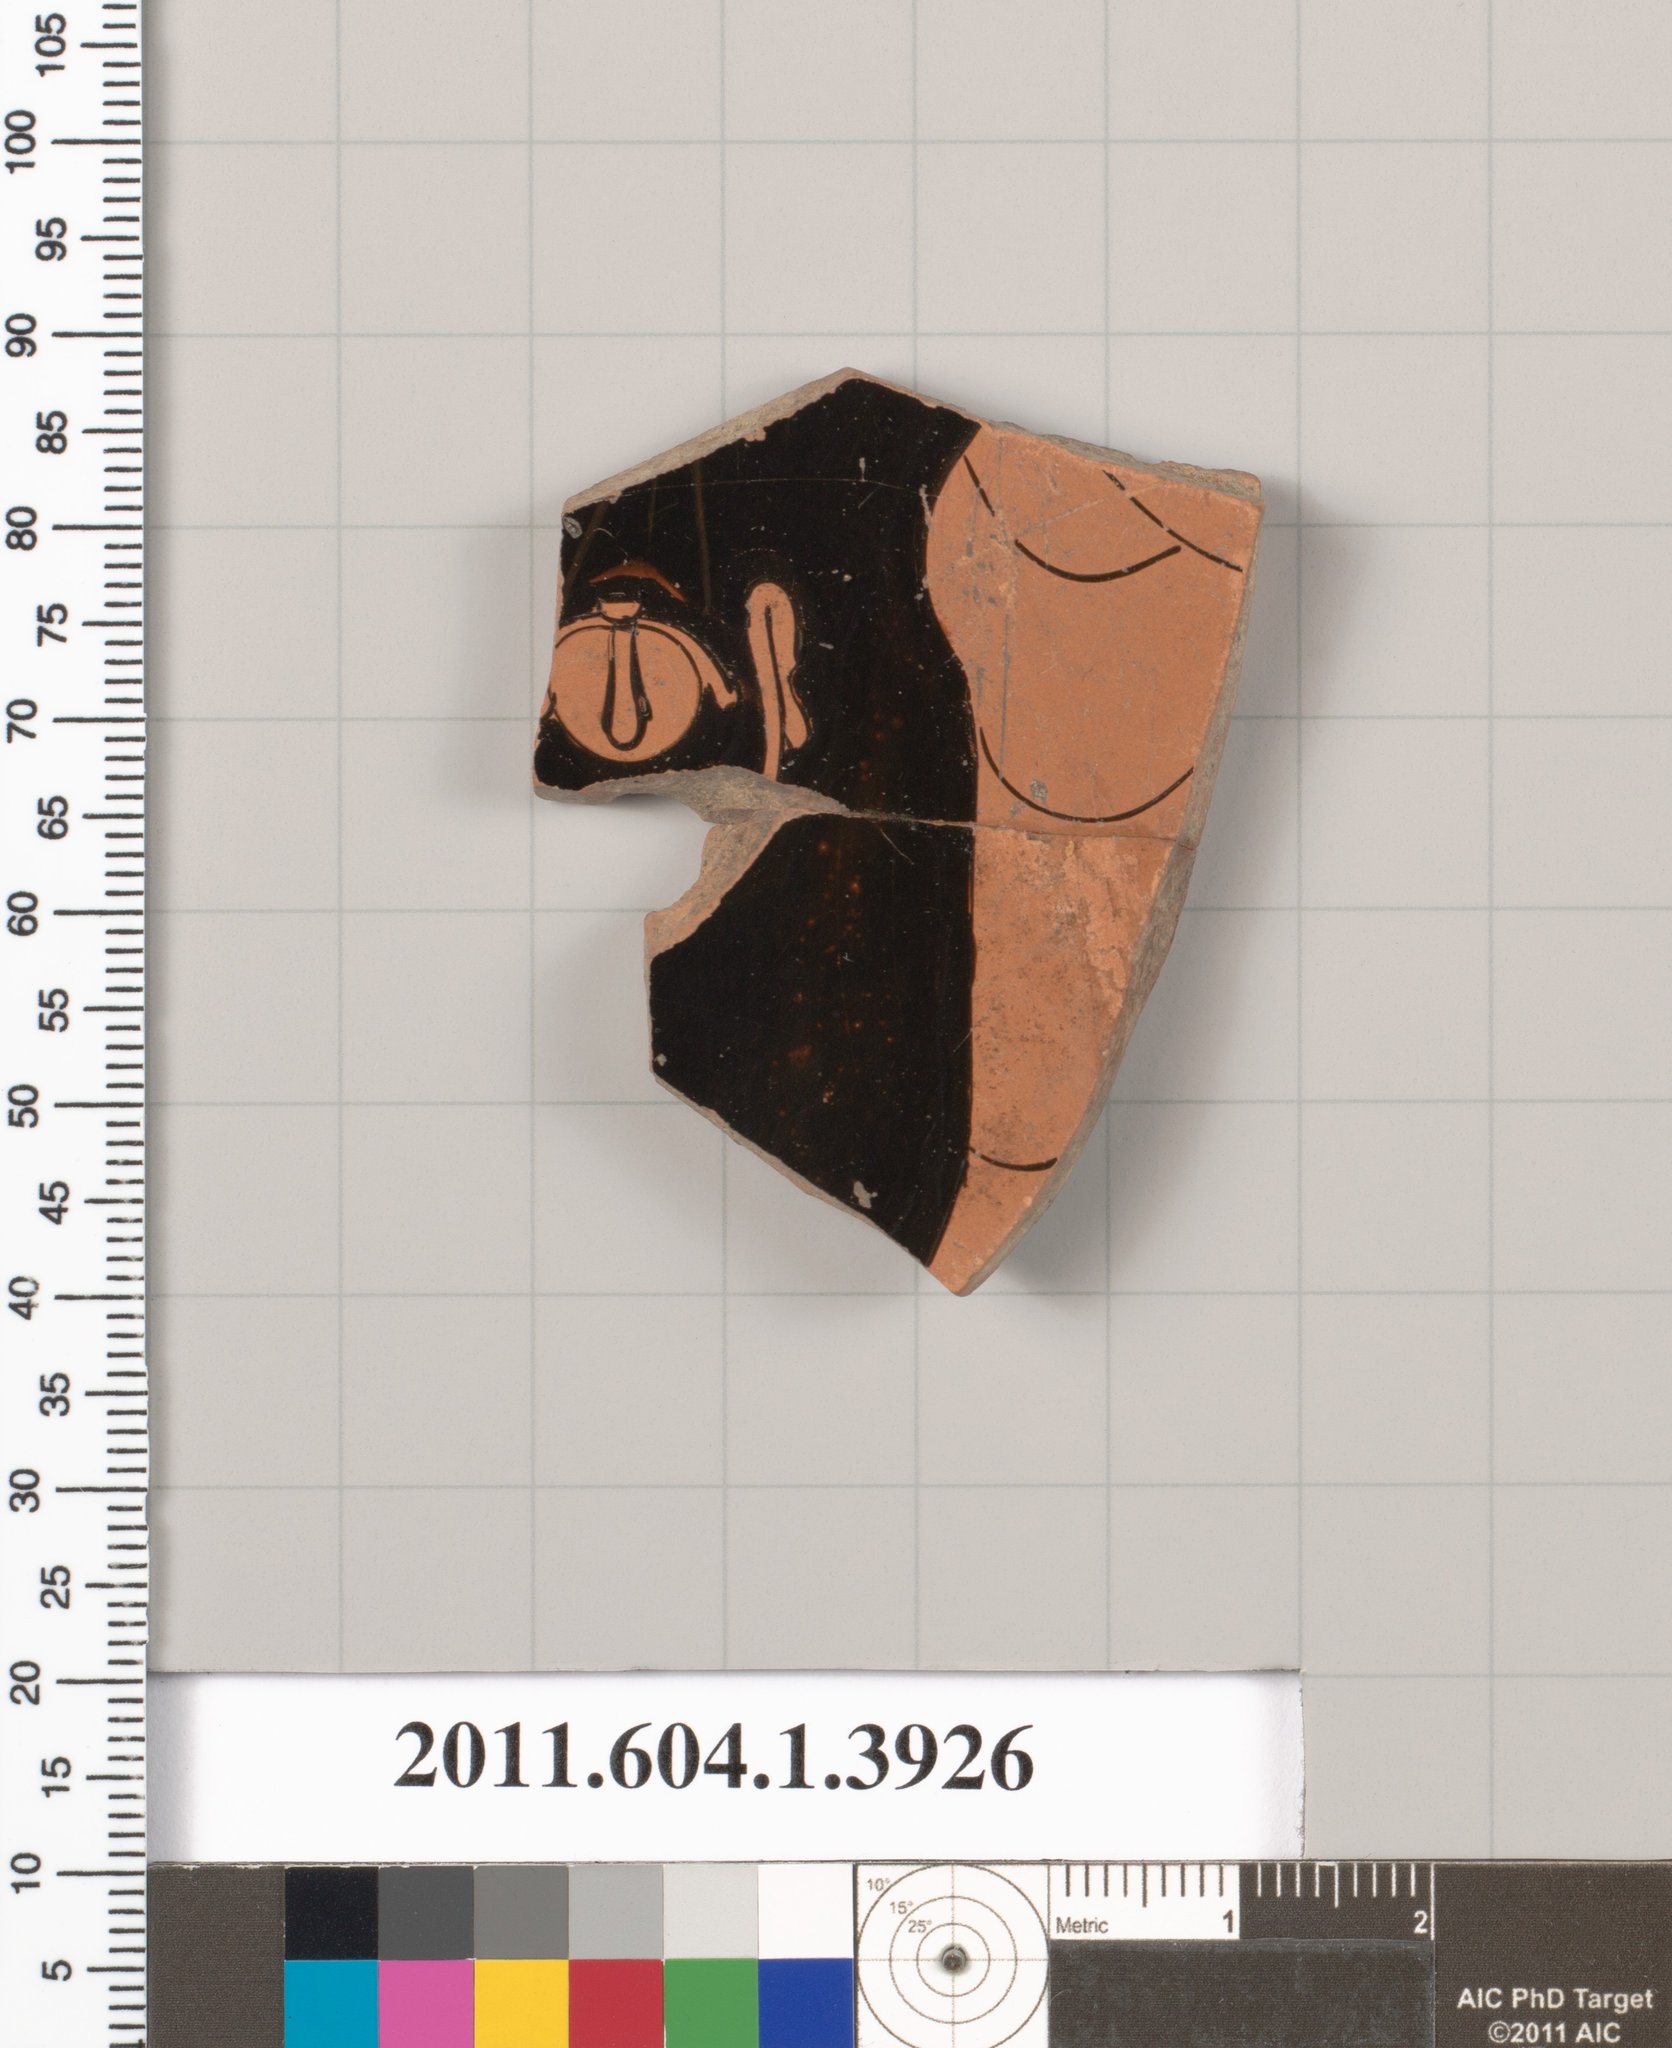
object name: kylix fragment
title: Terracotta fragment of a kylix (drinking cup)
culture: greek, attic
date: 510-480 BCE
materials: terracotta